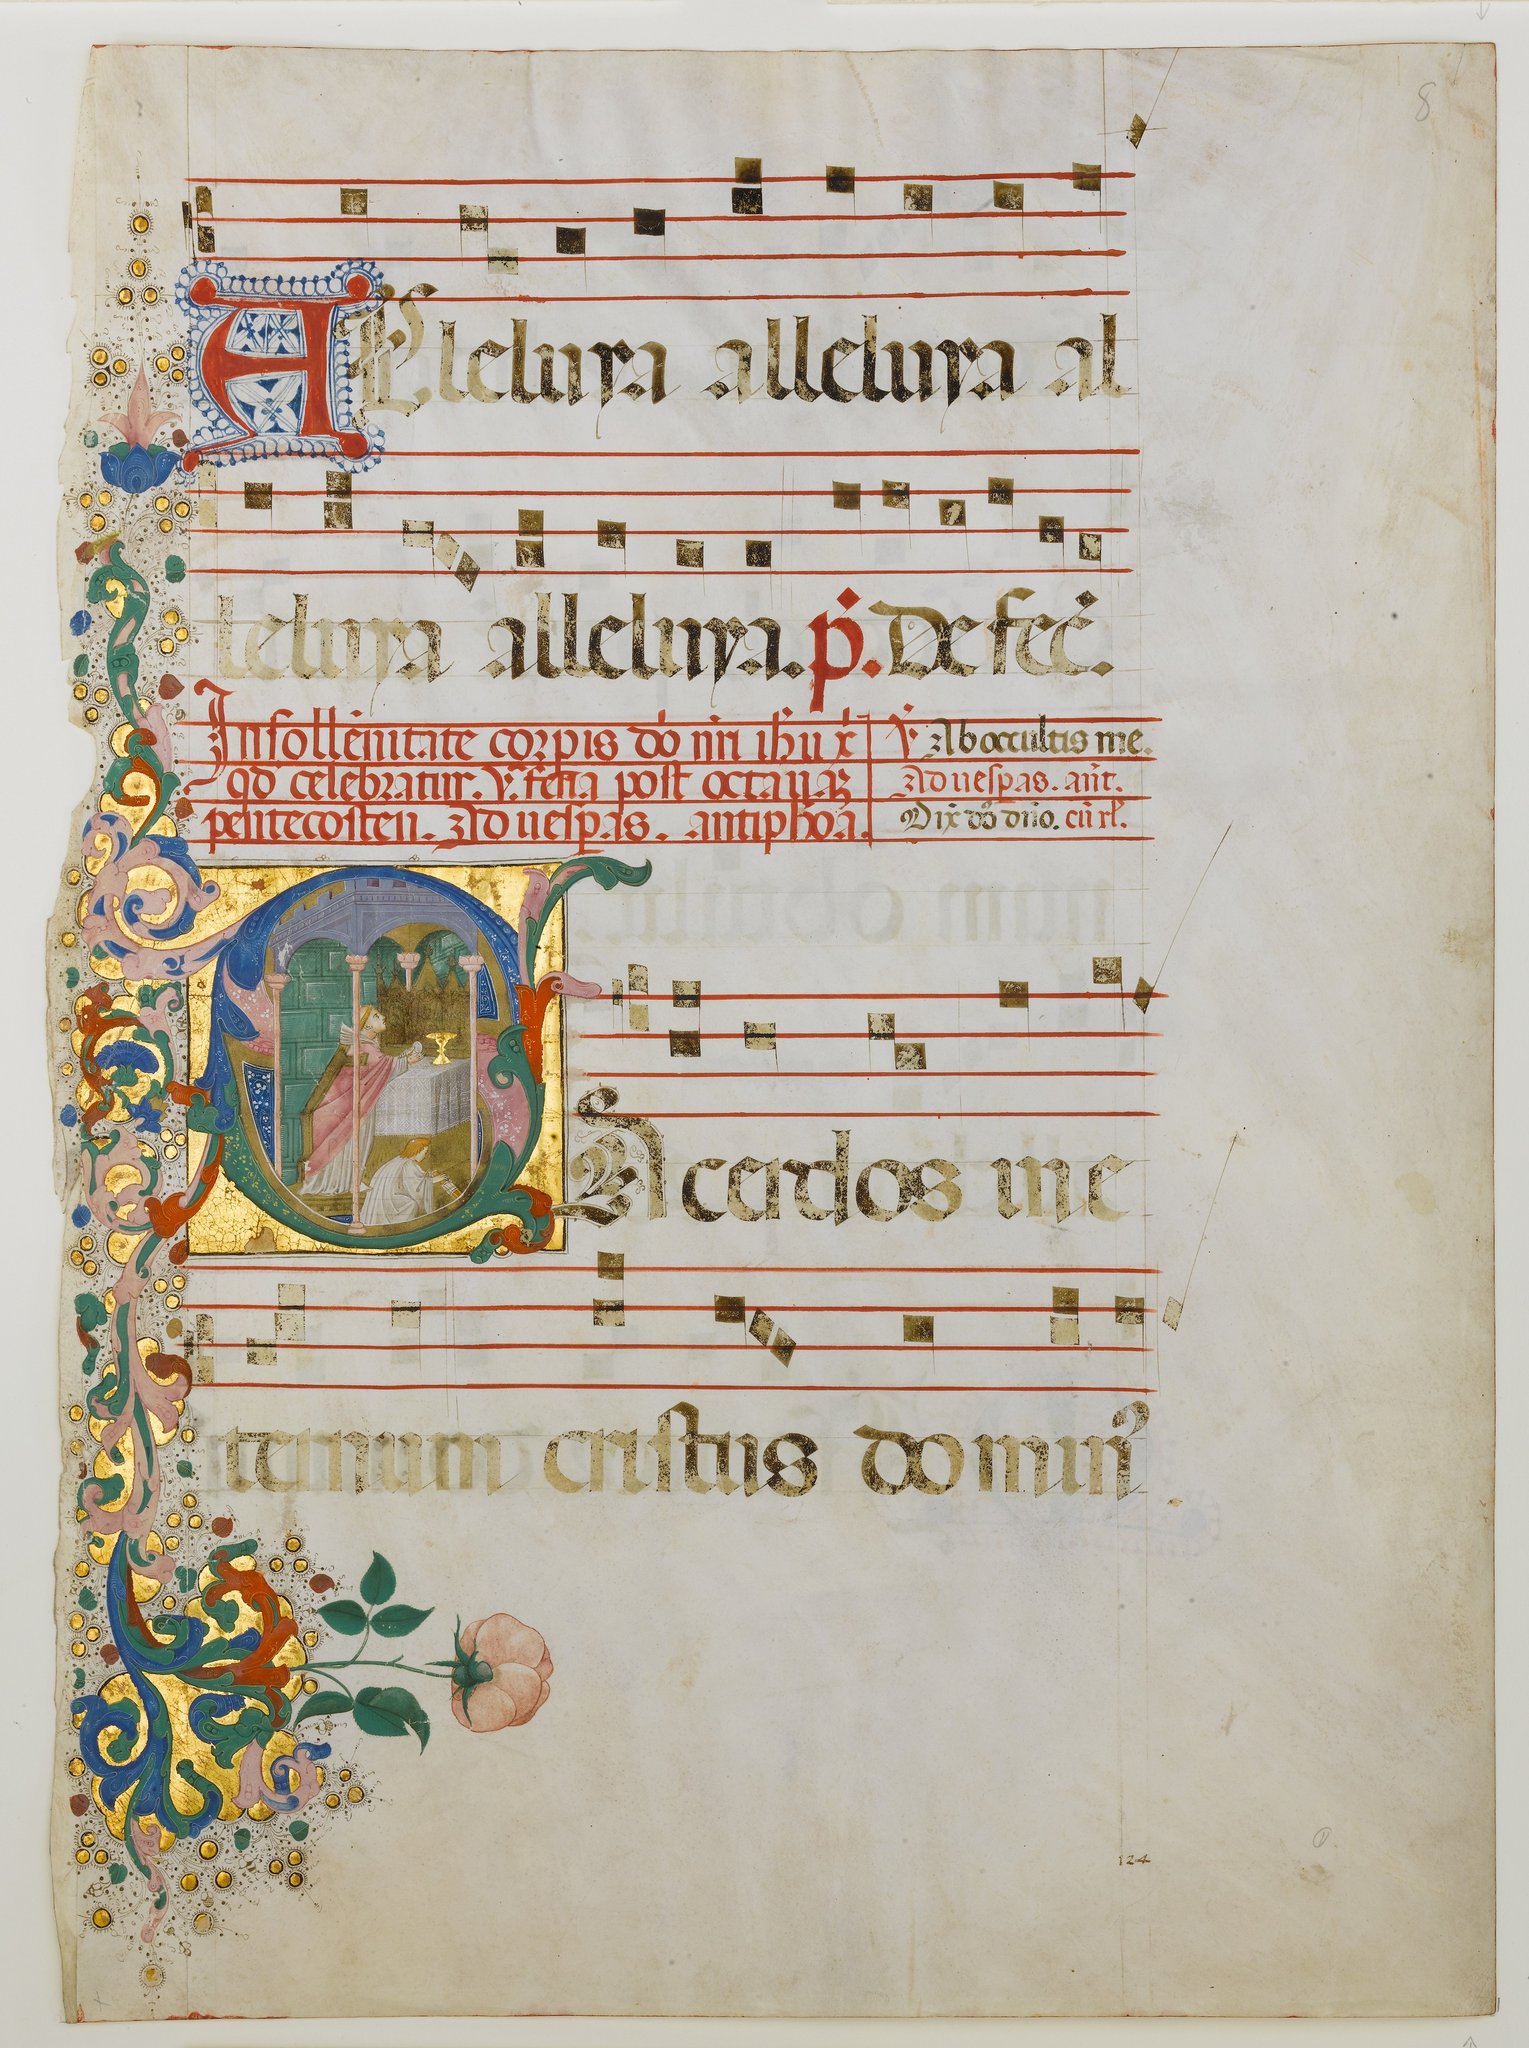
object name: antiphonary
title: Manuscript Leaf with the Celebration of a Mass in an Initial S, from an Antiphonary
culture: italian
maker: master of the riccardiana lactantius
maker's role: artist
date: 1451-1500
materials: gold, ink, parchment, paint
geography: italy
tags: monks